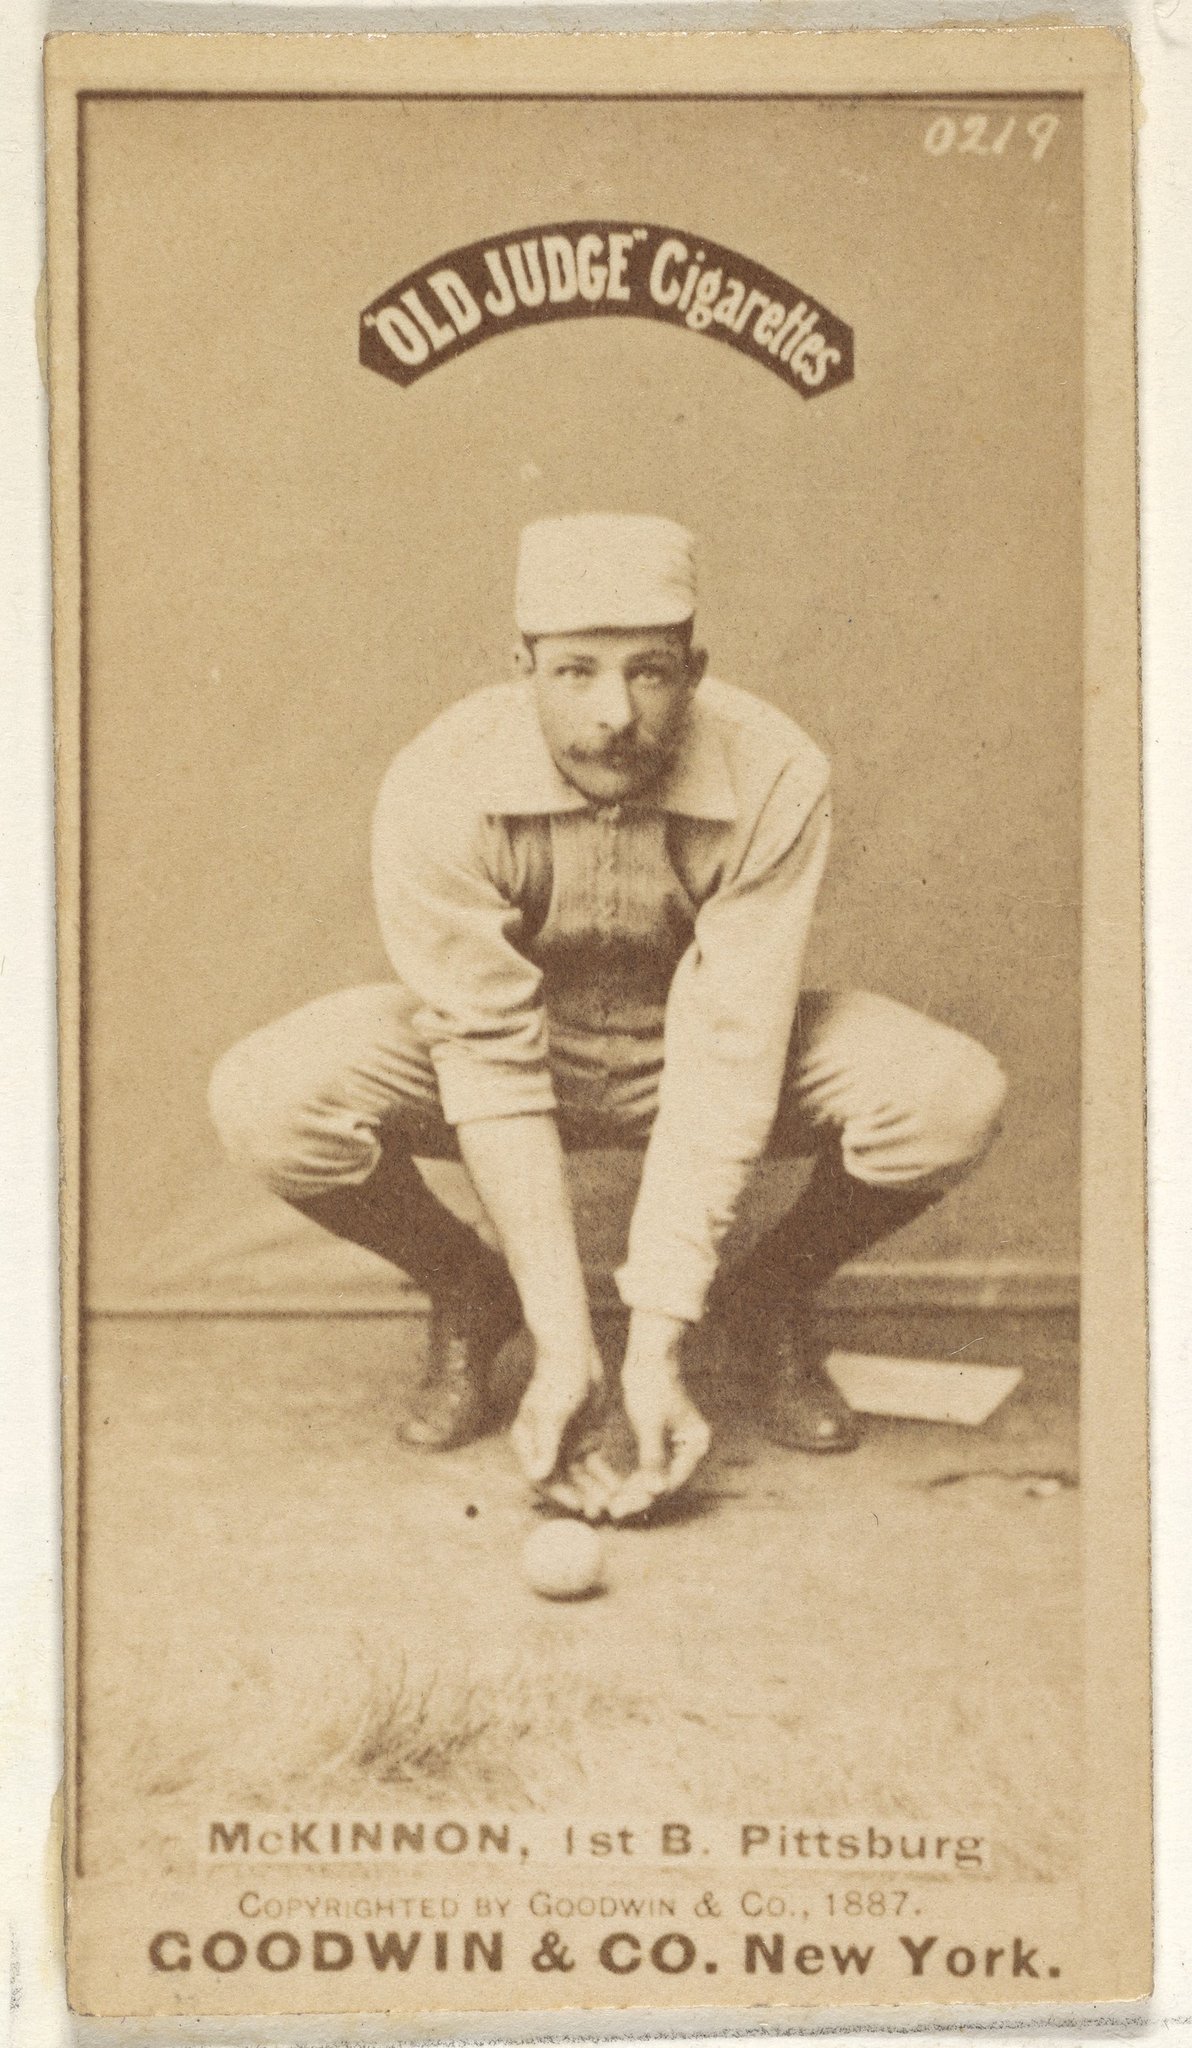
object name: baseball card, photograph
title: Alex McKinnon, 1st Base, Pittsburgh, from the Old Judge series (N172) for Old Judge Cigarettes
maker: goodwin & company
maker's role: publisher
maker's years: 1850-1950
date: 1887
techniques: albumen silver print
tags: men,baseball,athletes